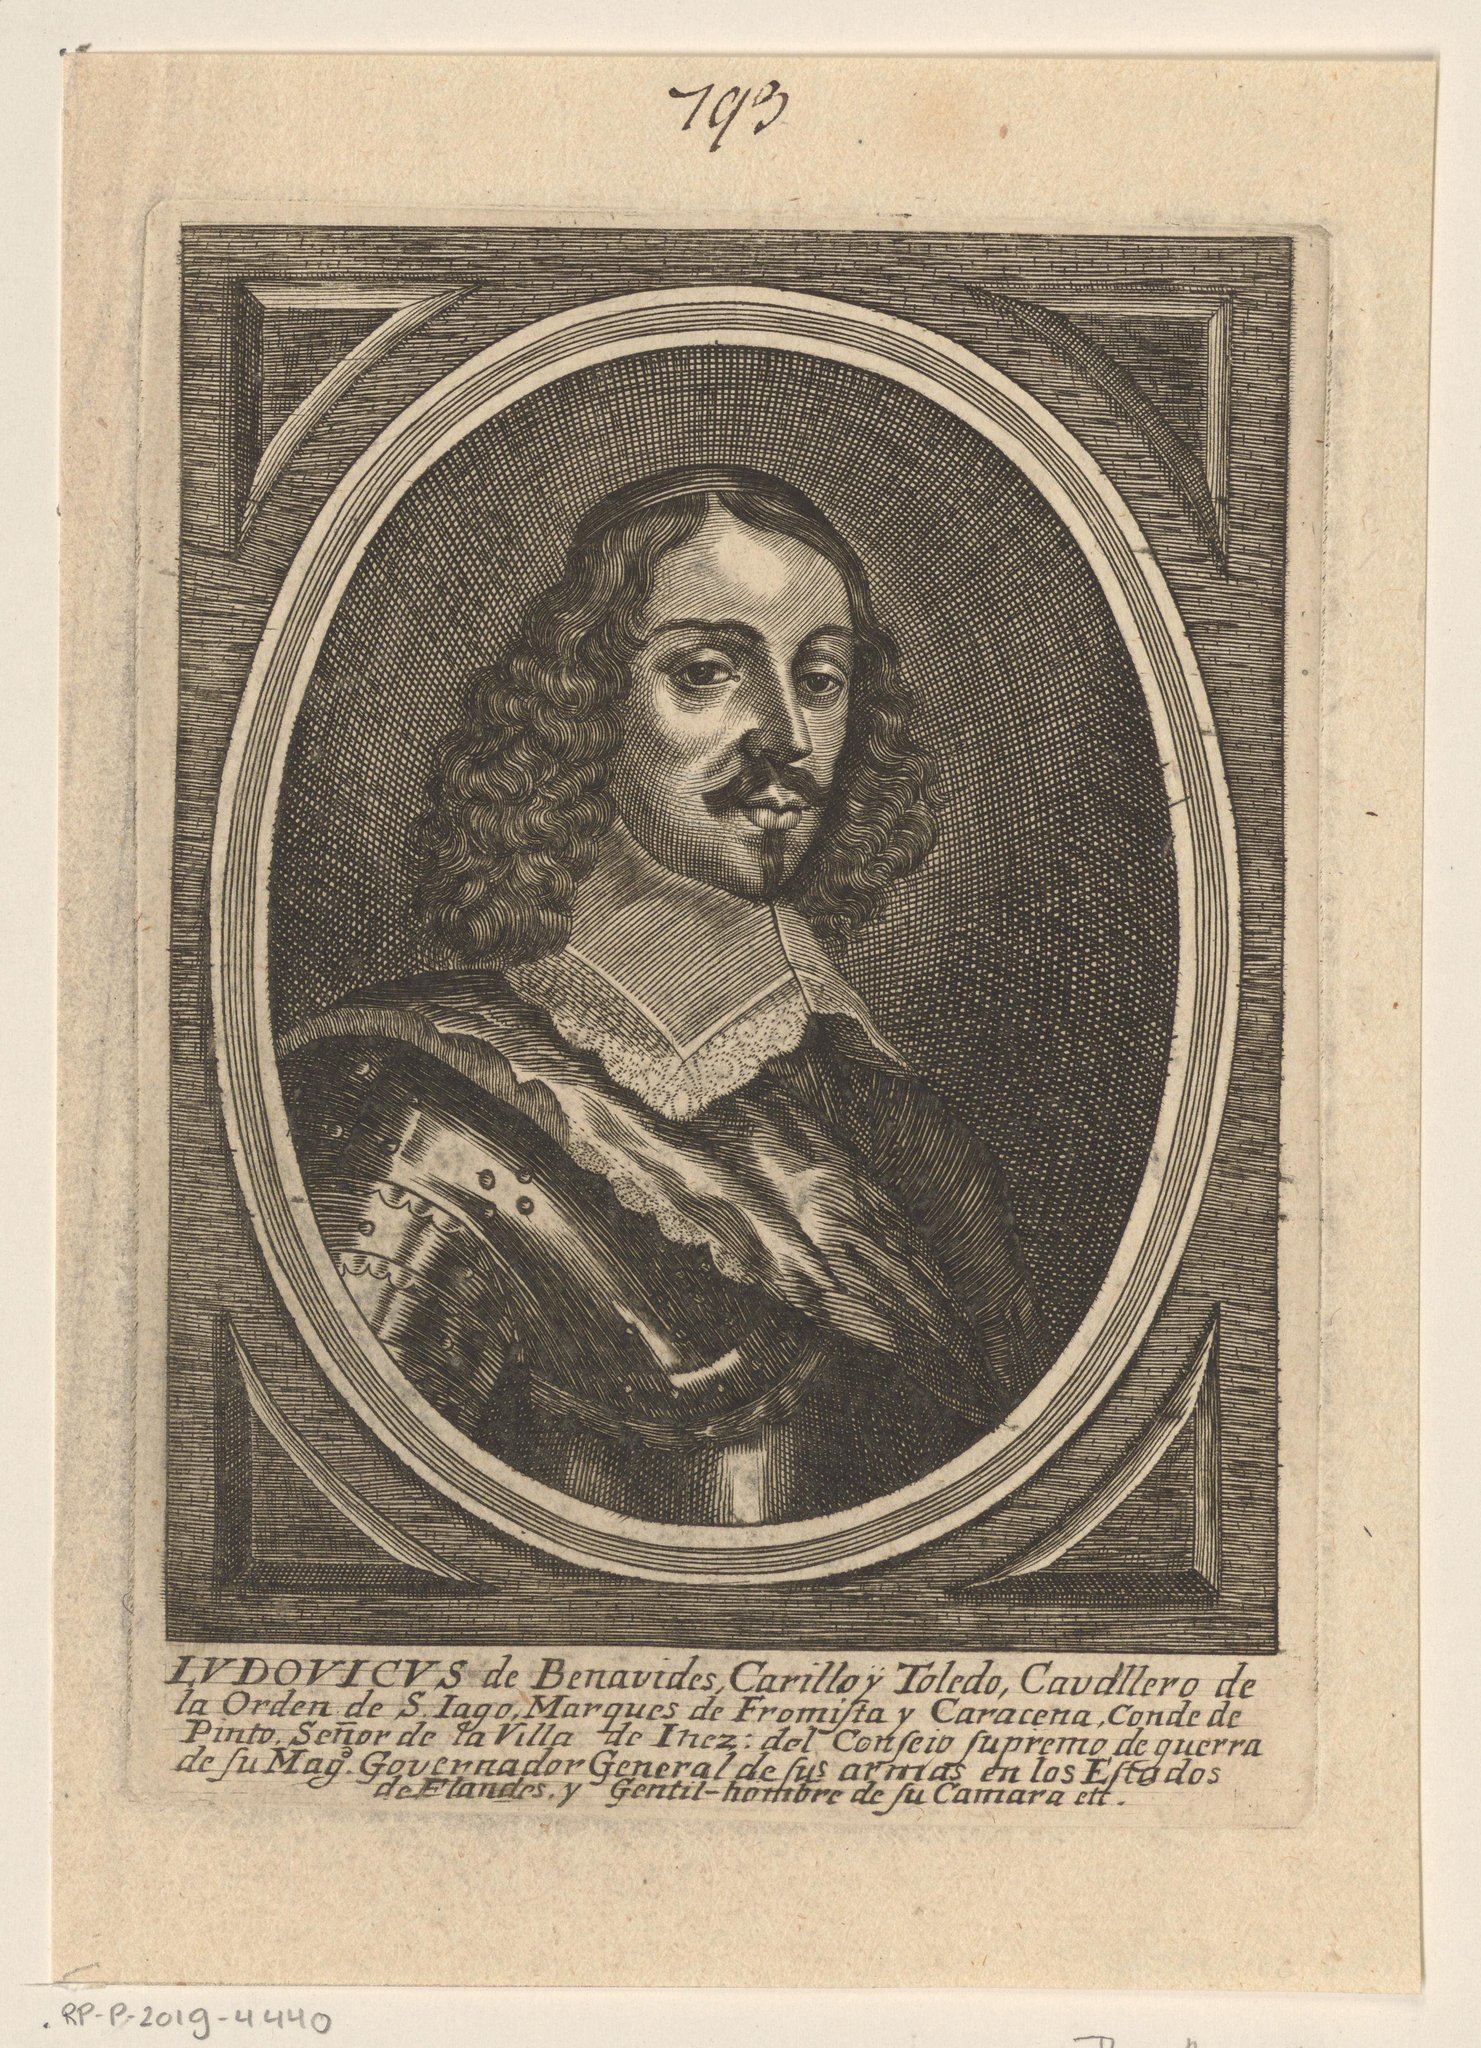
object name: print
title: Portret van Luis de Benavides Carillo de Toledo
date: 1650-1699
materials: paper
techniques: engraving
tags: armour, historical persons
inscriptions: inscription: ‘193’, collector's mark: Lugt 2228